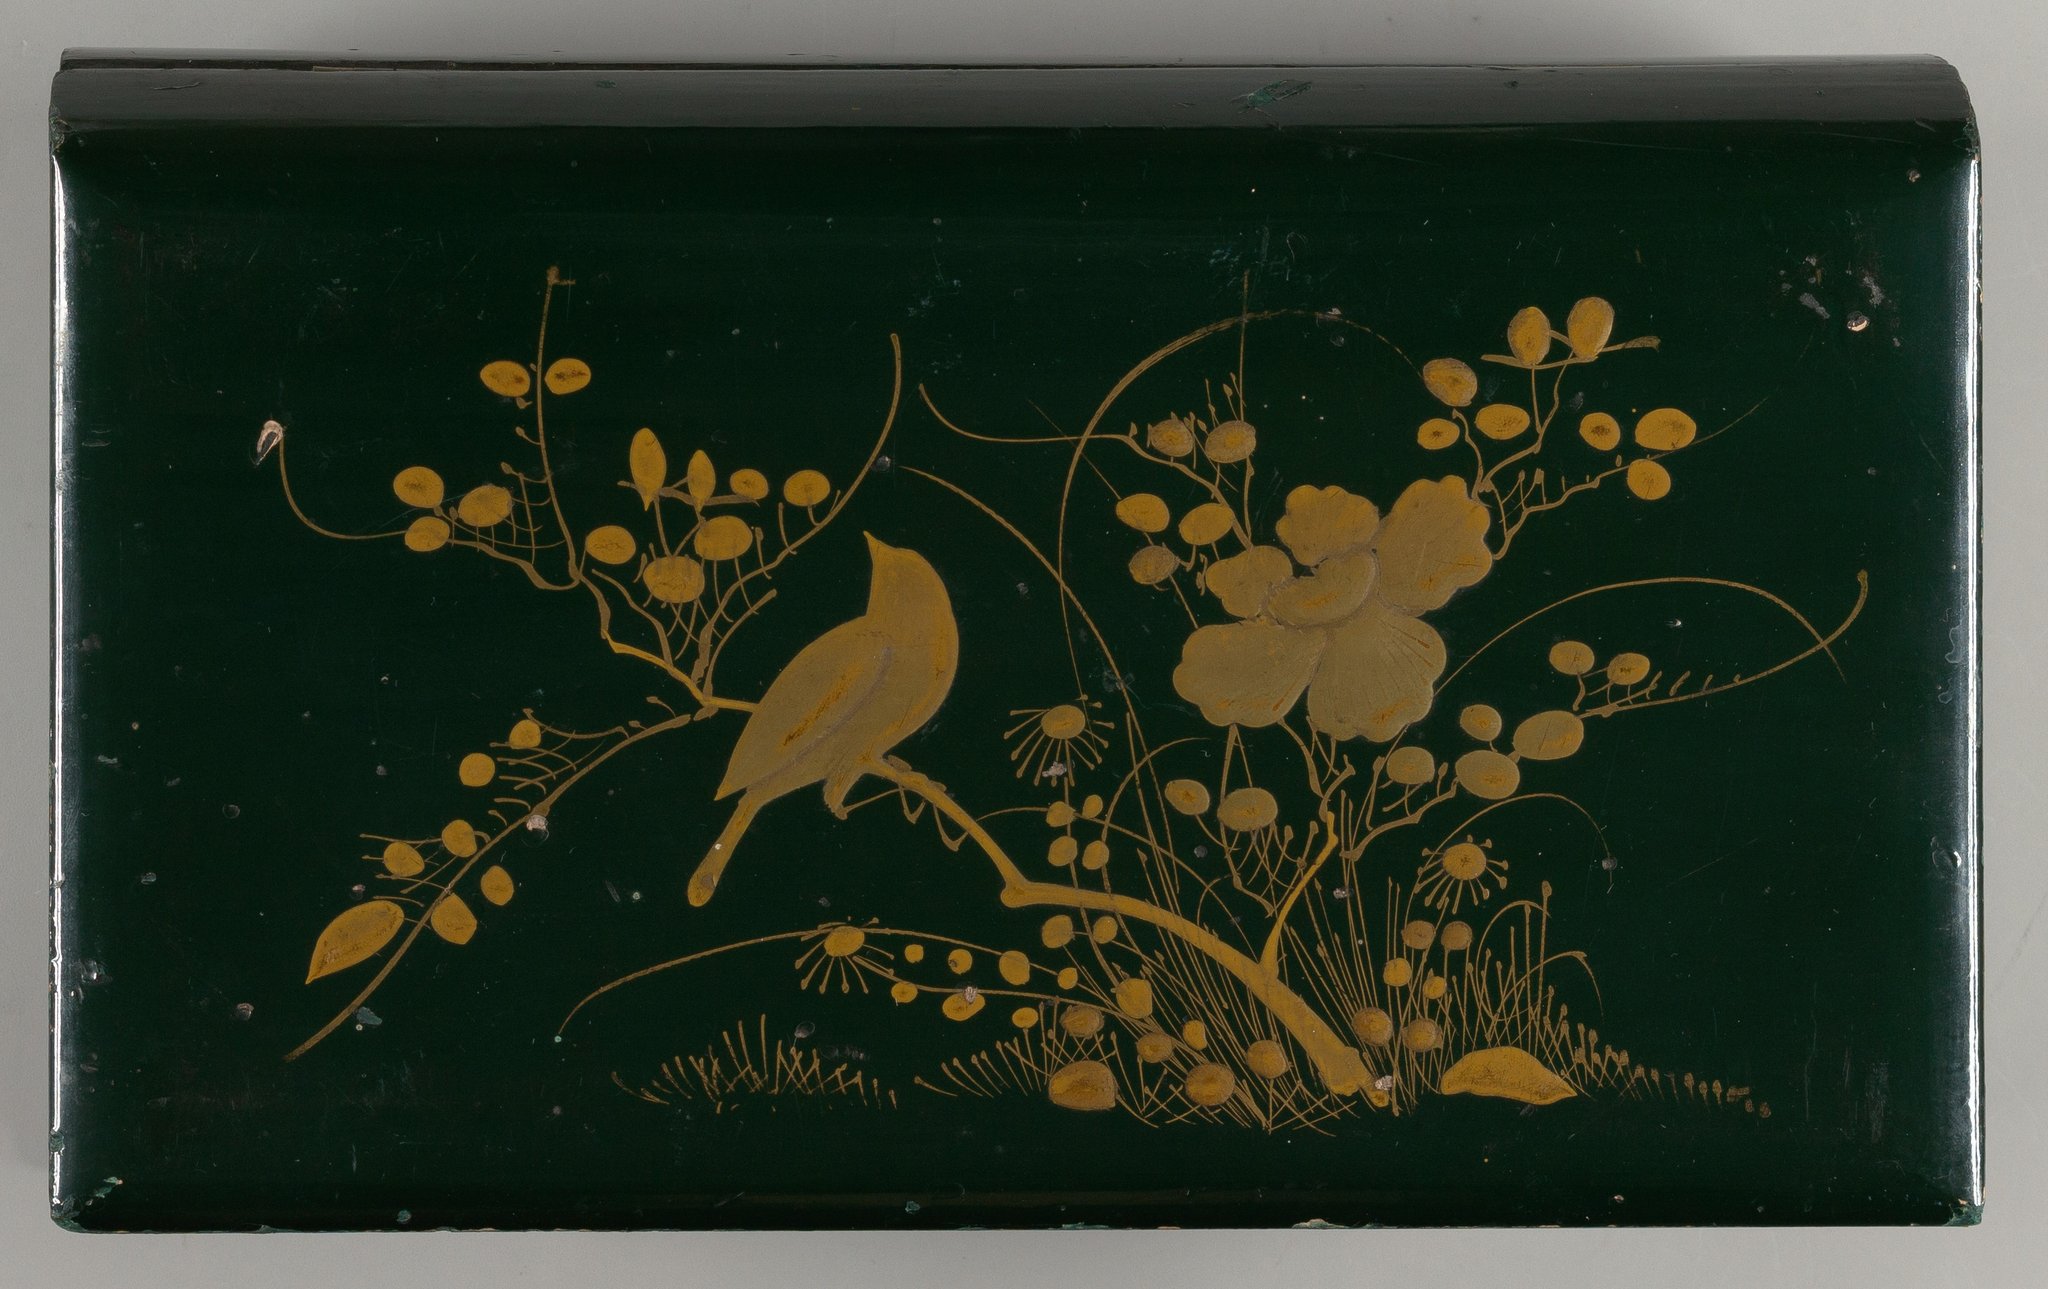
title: Locking biscuit box in book form : Biscuits Olibet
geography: france